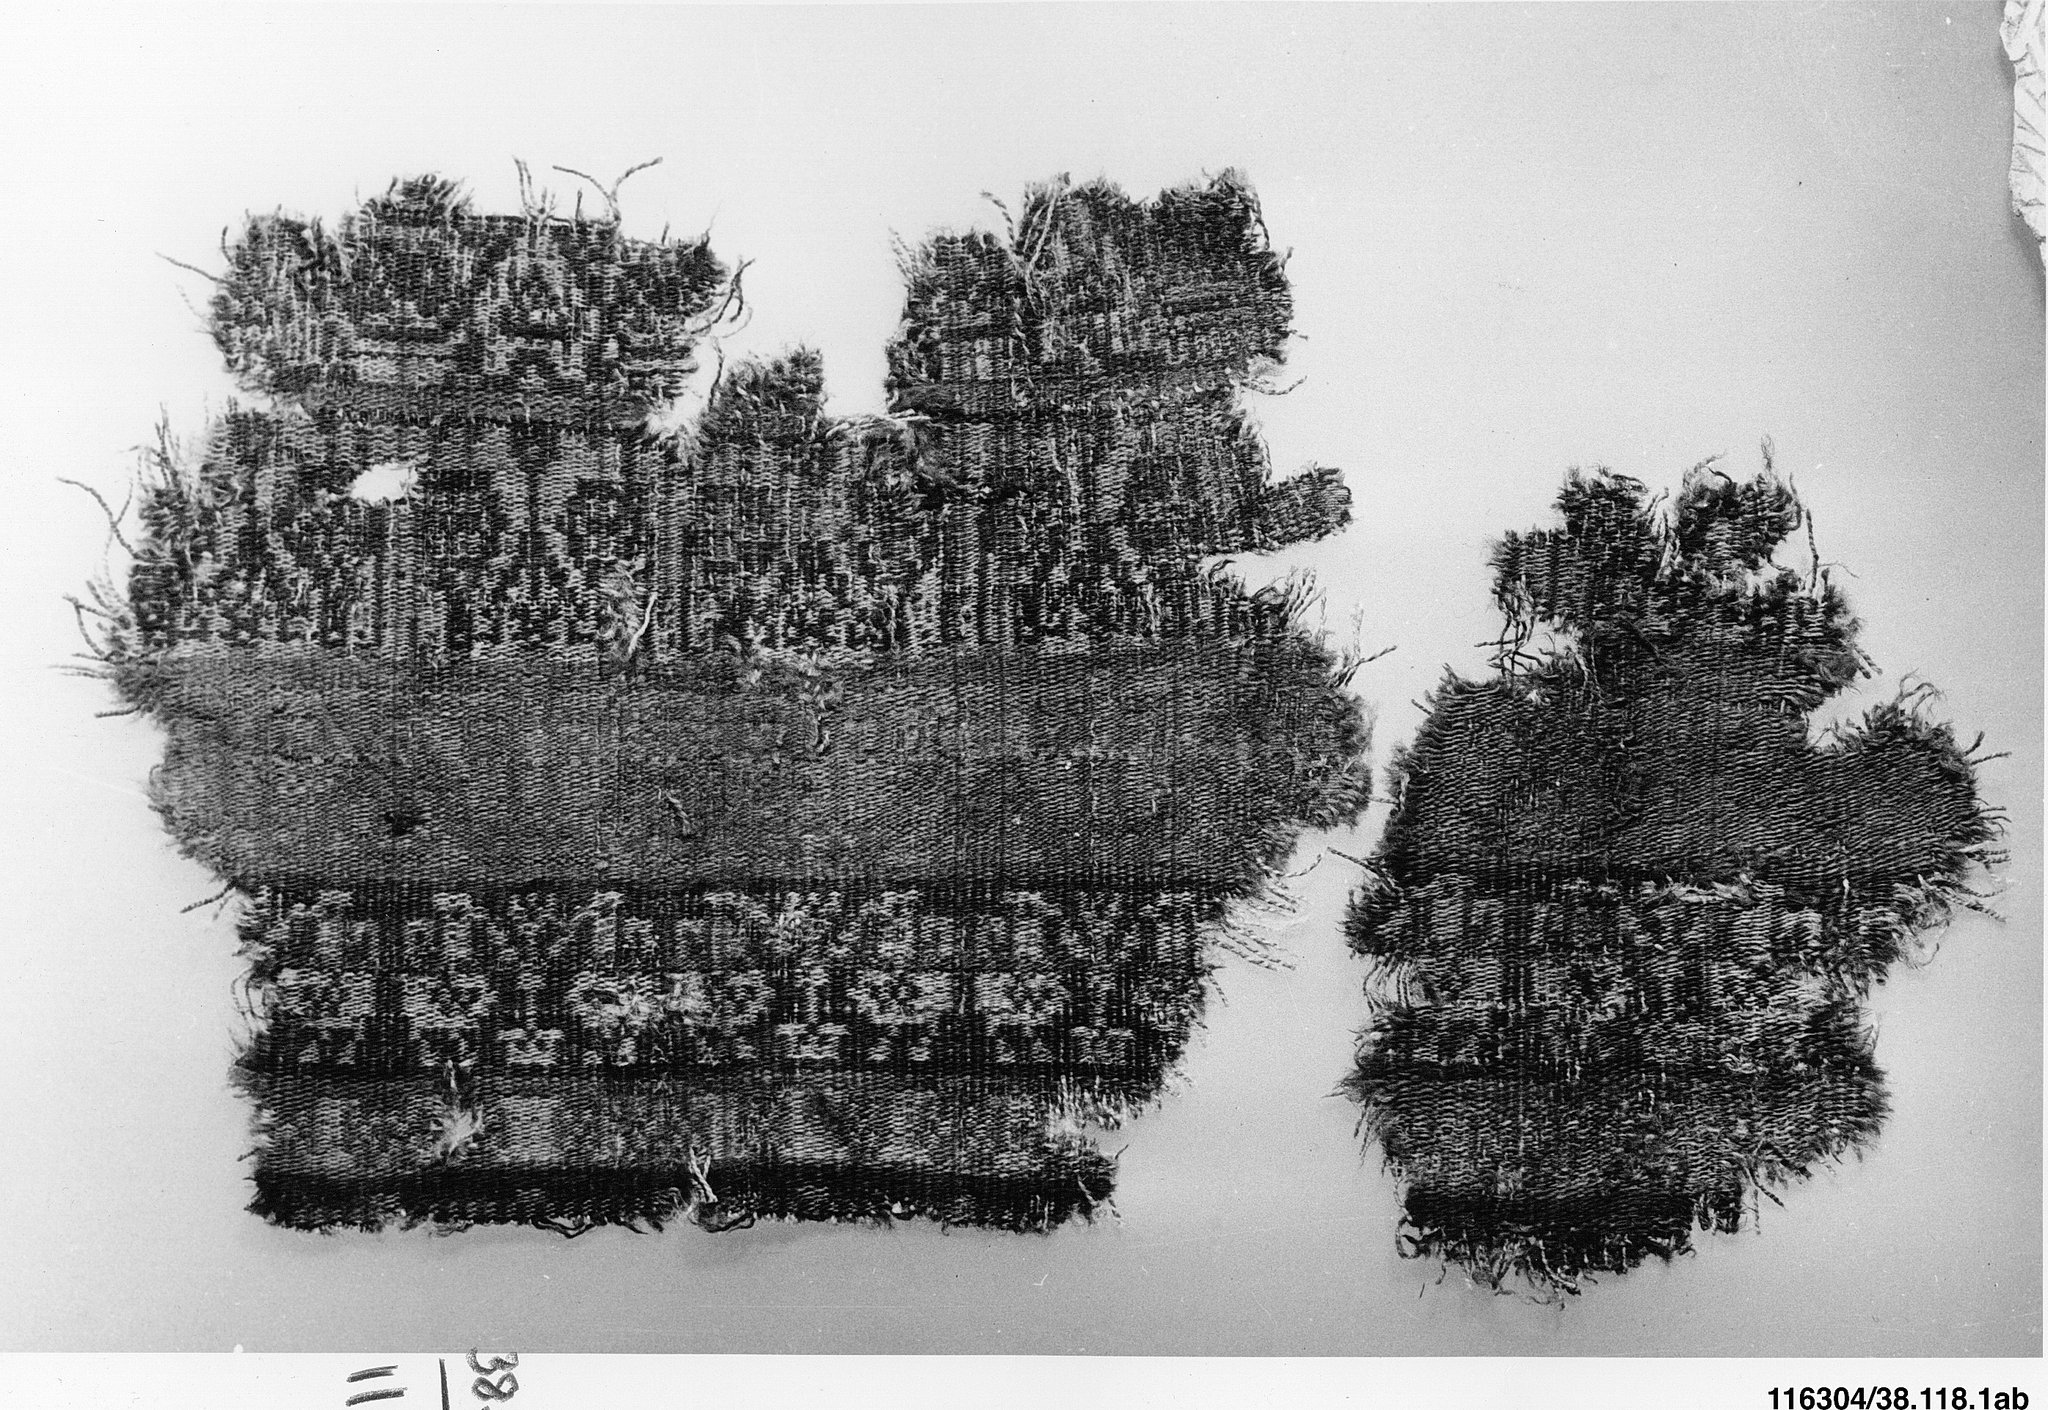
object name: textile fragment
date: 501-700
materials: wool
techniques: weave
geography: egypt